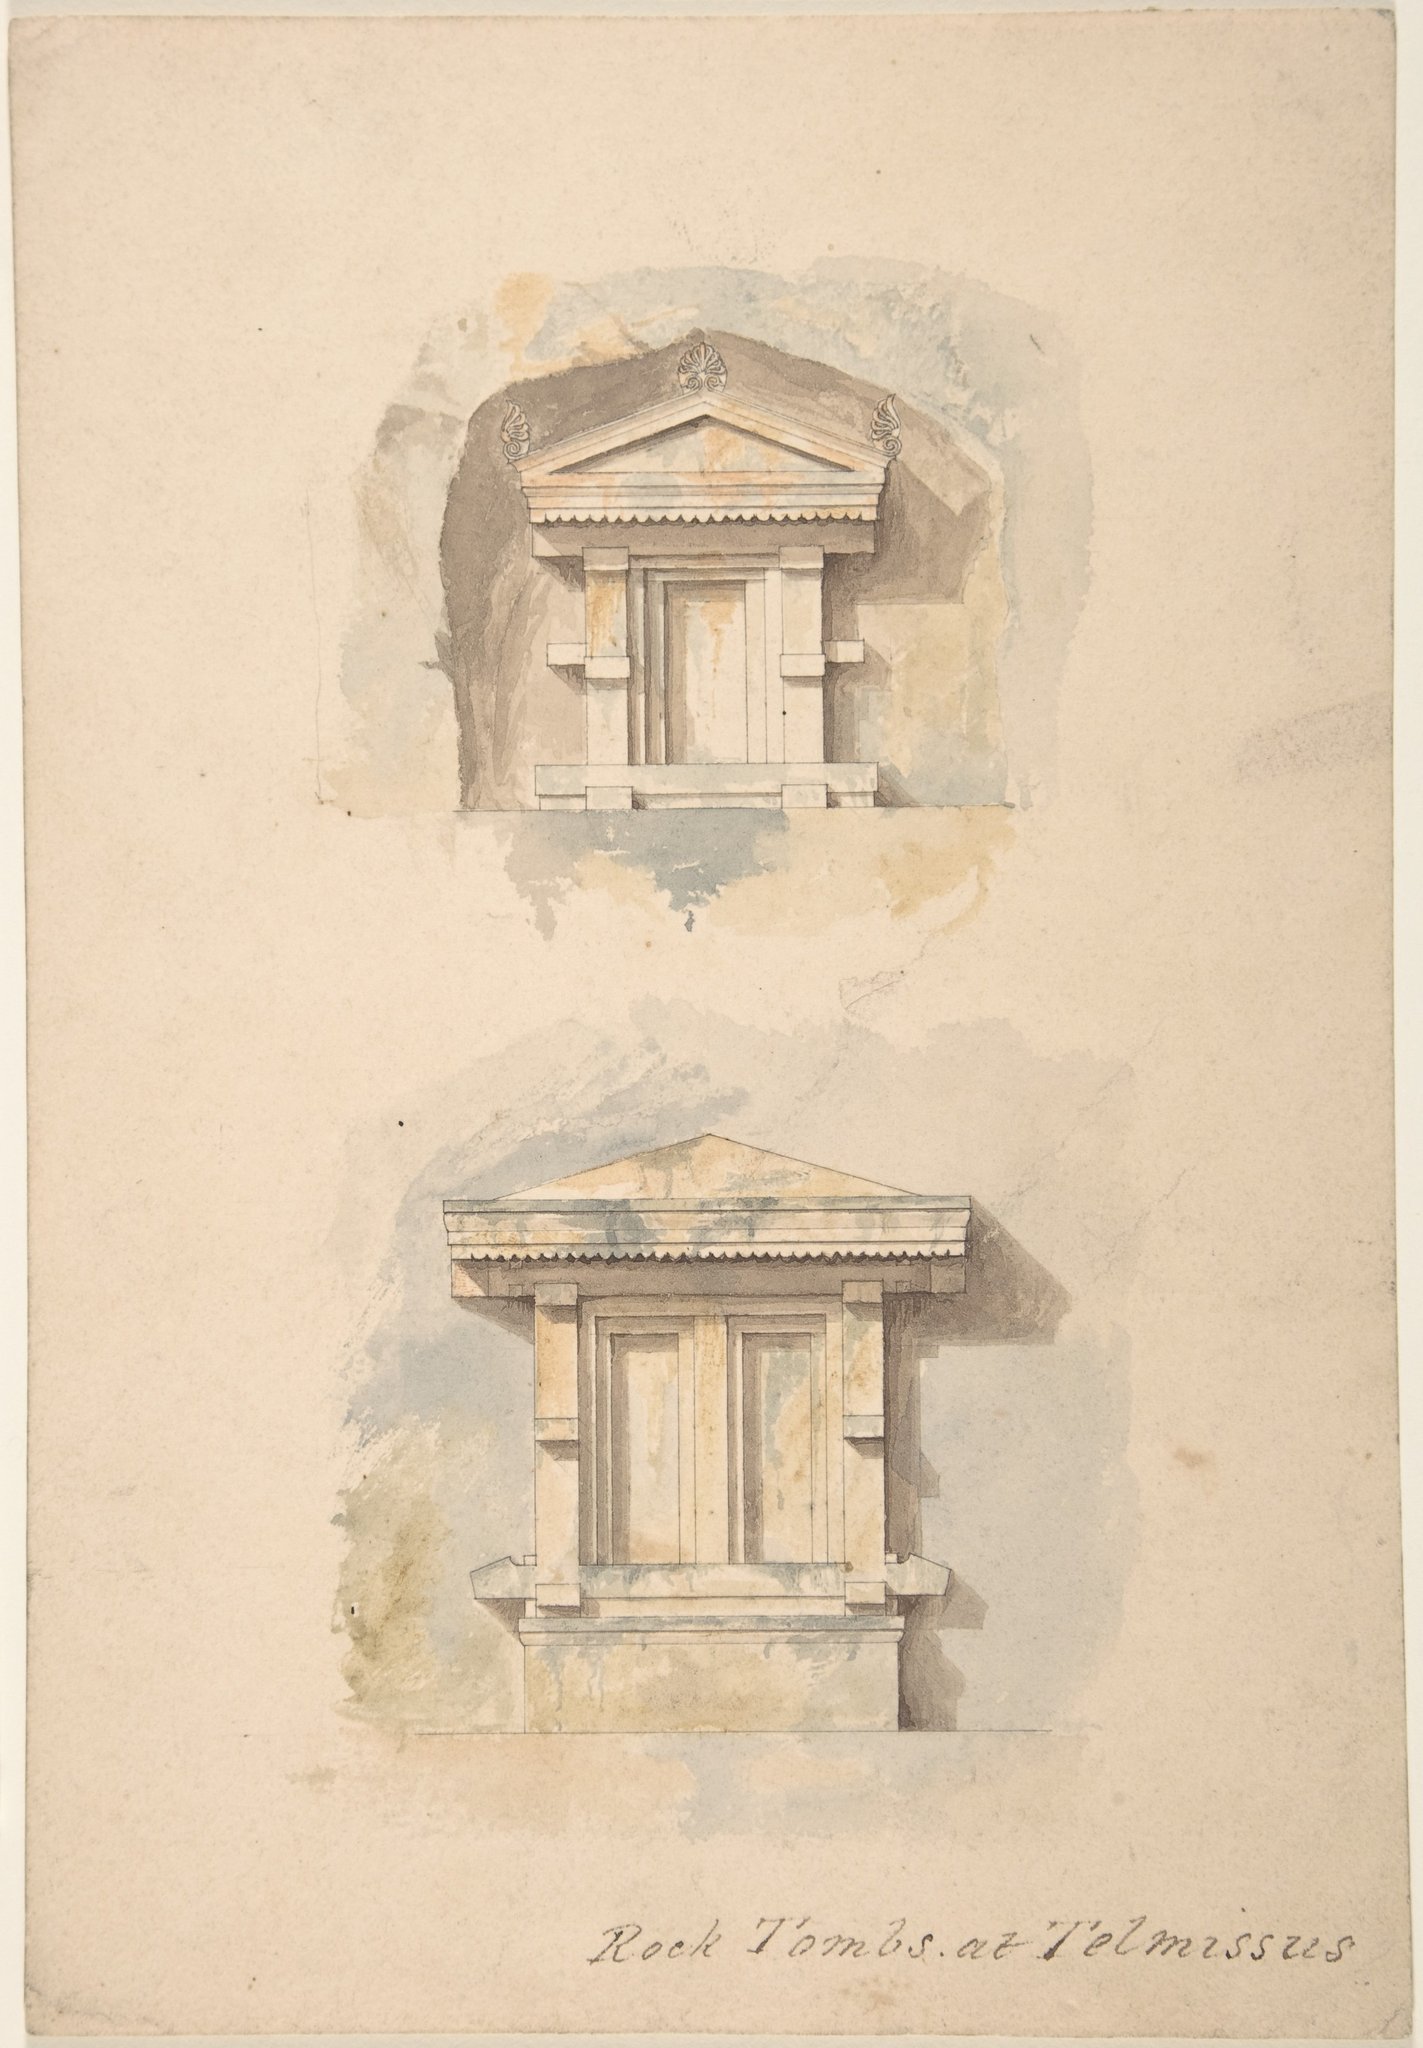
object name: drawing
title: Rock Tombs at Telmissus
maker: anonymous, british, 19th century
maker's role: artist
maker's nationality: british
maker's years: 1800-1900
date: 1801-1900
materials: ink, watercolor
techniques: pen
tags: tombs